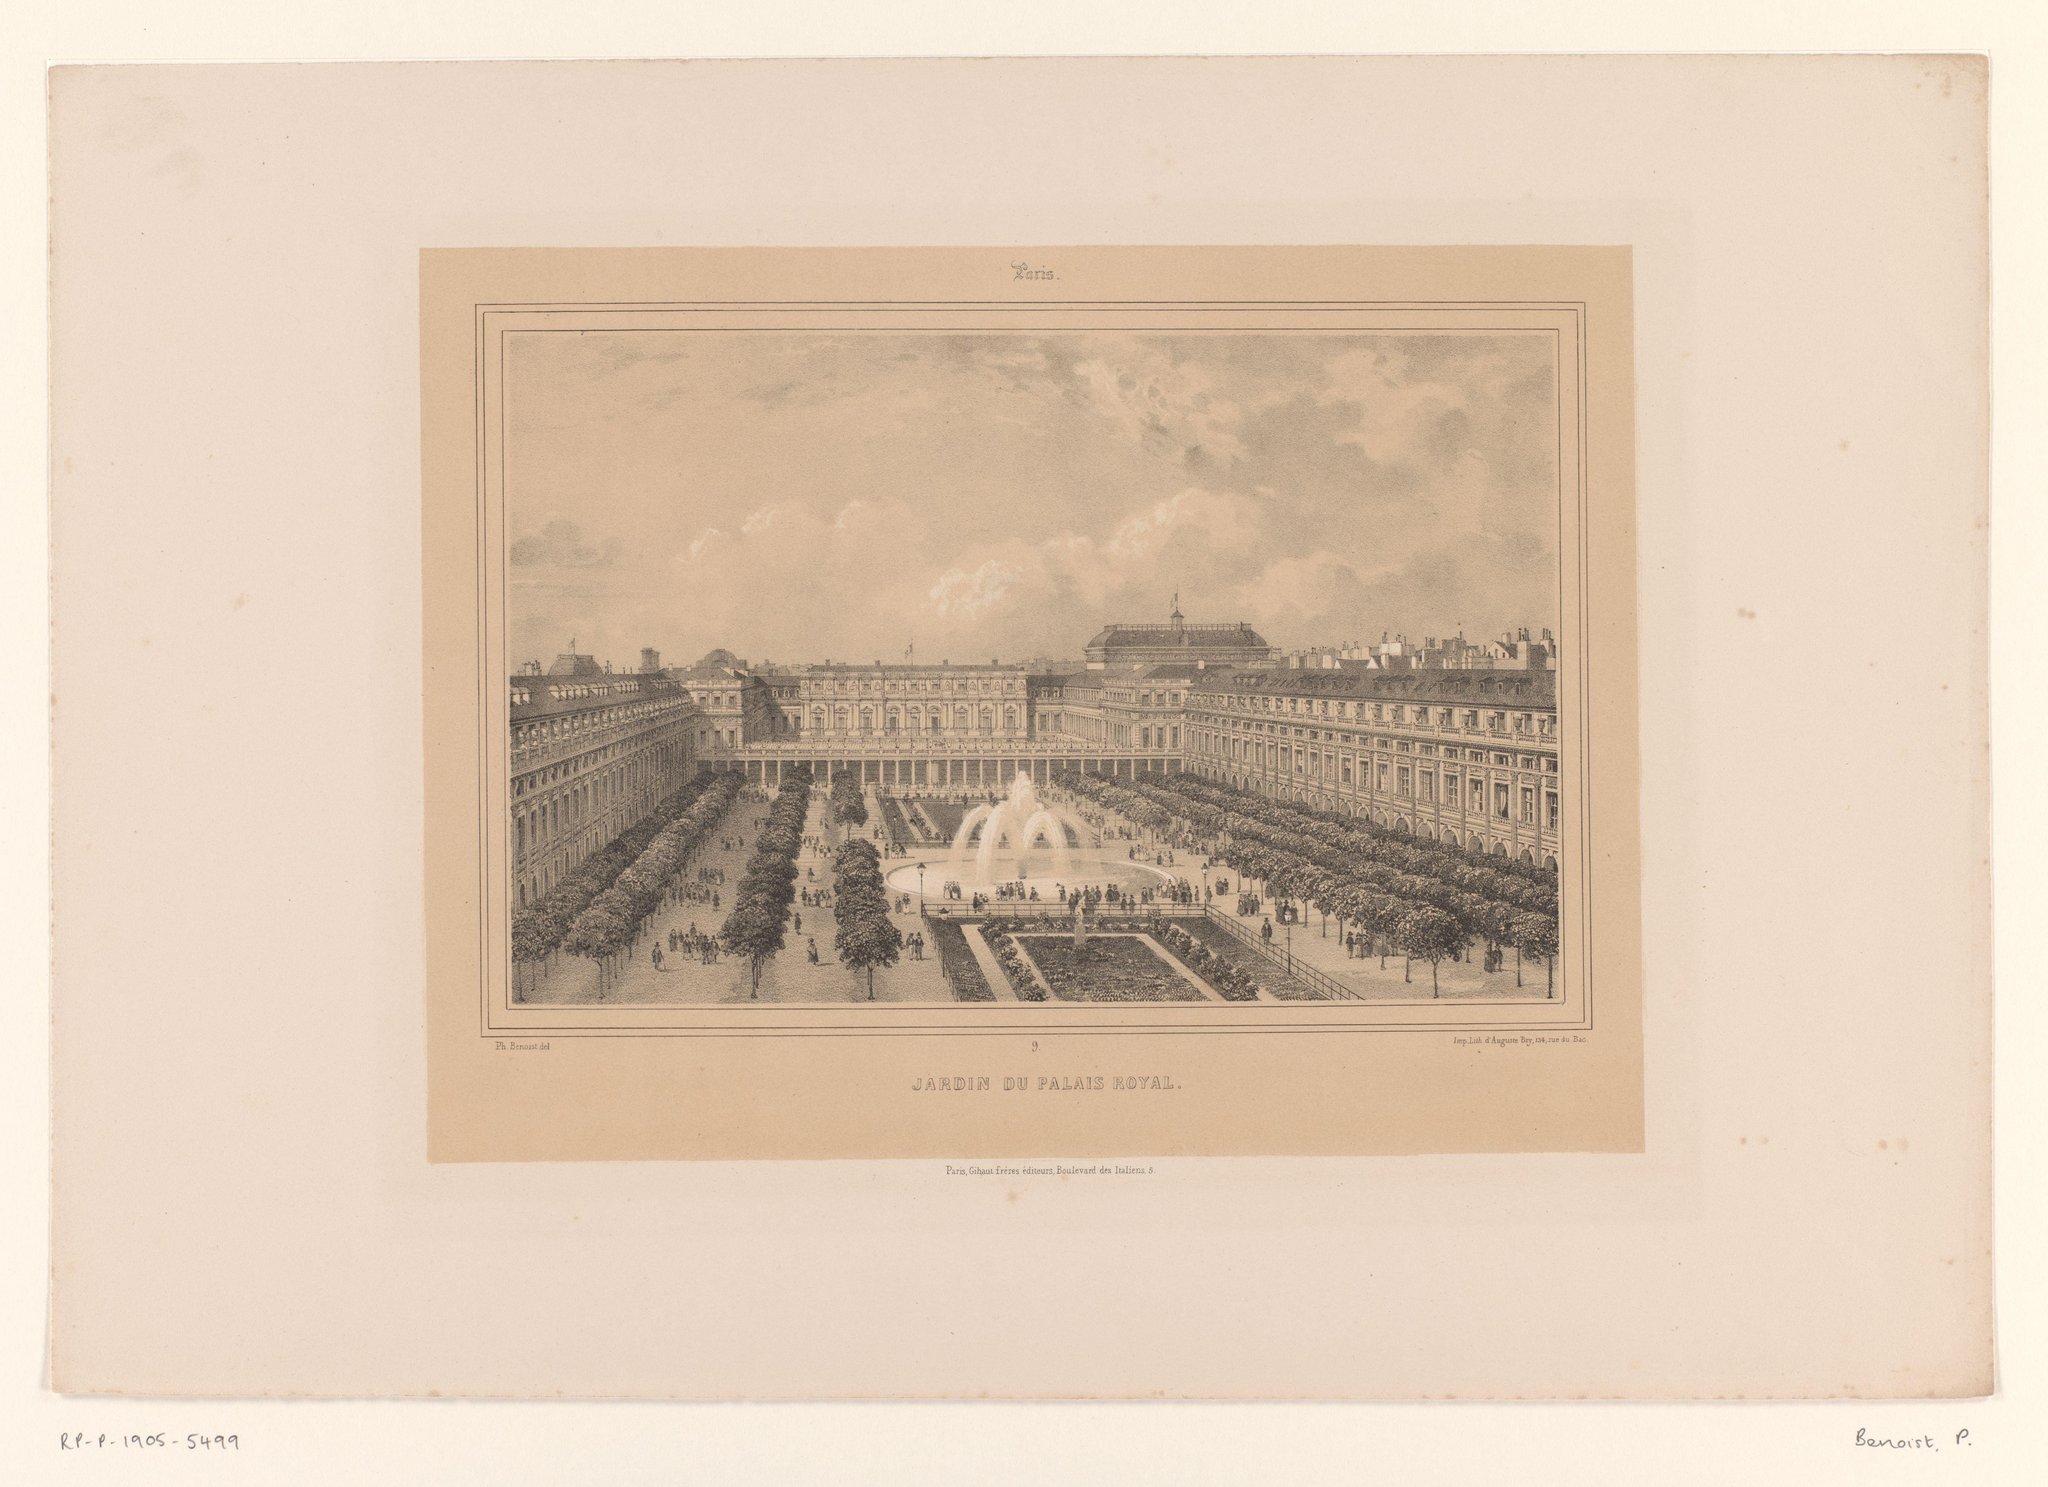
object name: print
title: Jardin du Palais Royal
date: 1843-1844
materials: paper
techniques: tone lithography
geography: paris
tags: palace, french or architectonic garden; formal garden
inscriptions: collector's mark: Lugt 2228a